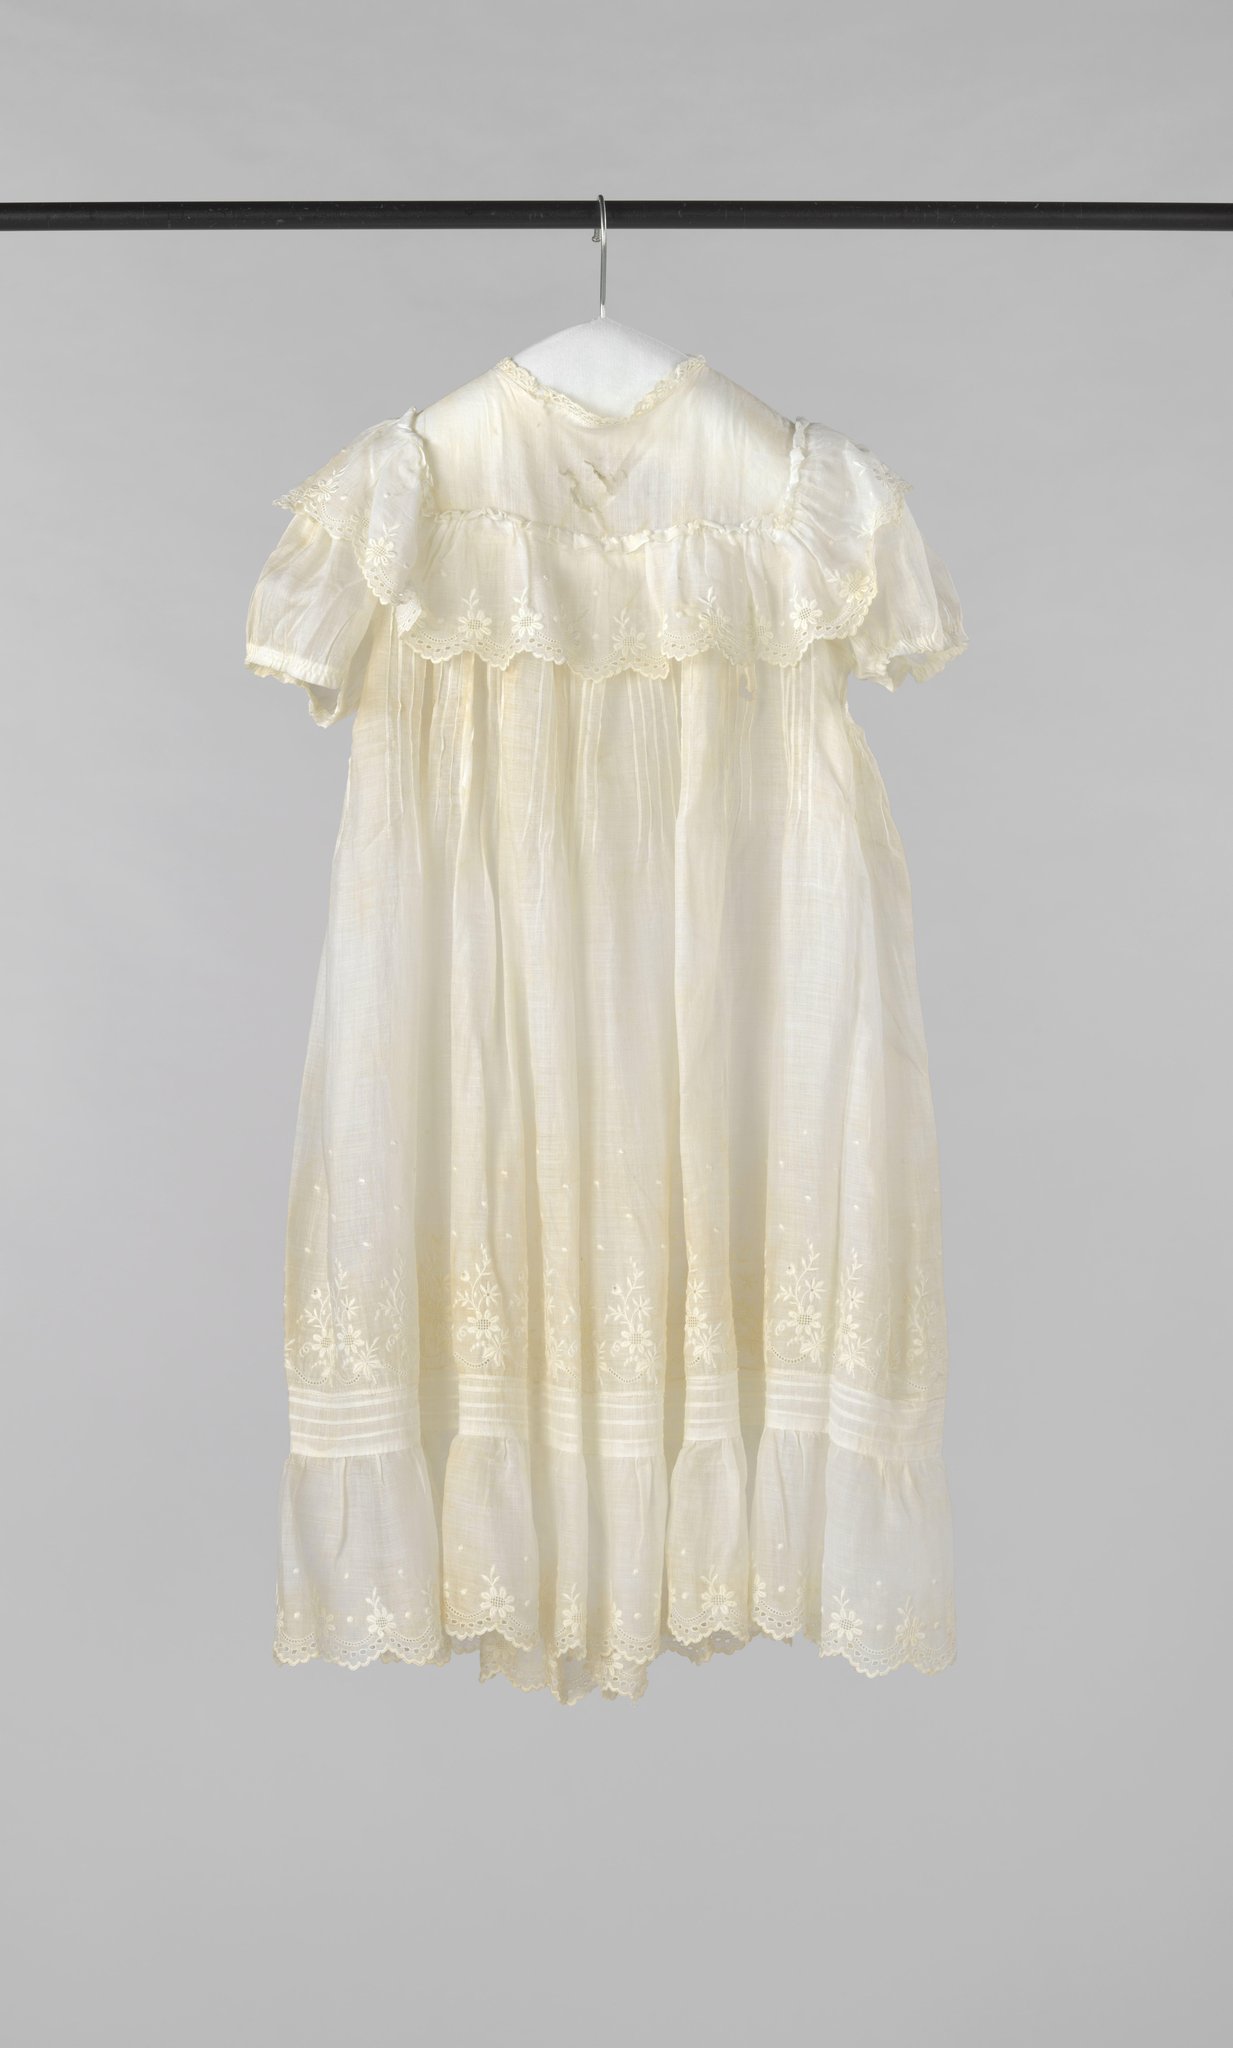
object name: clothing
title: Kinderjurk met korte pofmouw en achtersluiting van wit katoen versierd met Engels borduurwerk, oprijgen en langs de hals met een kantrand.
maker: Anonymous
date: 1900-1930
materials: cotton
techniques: embroidered